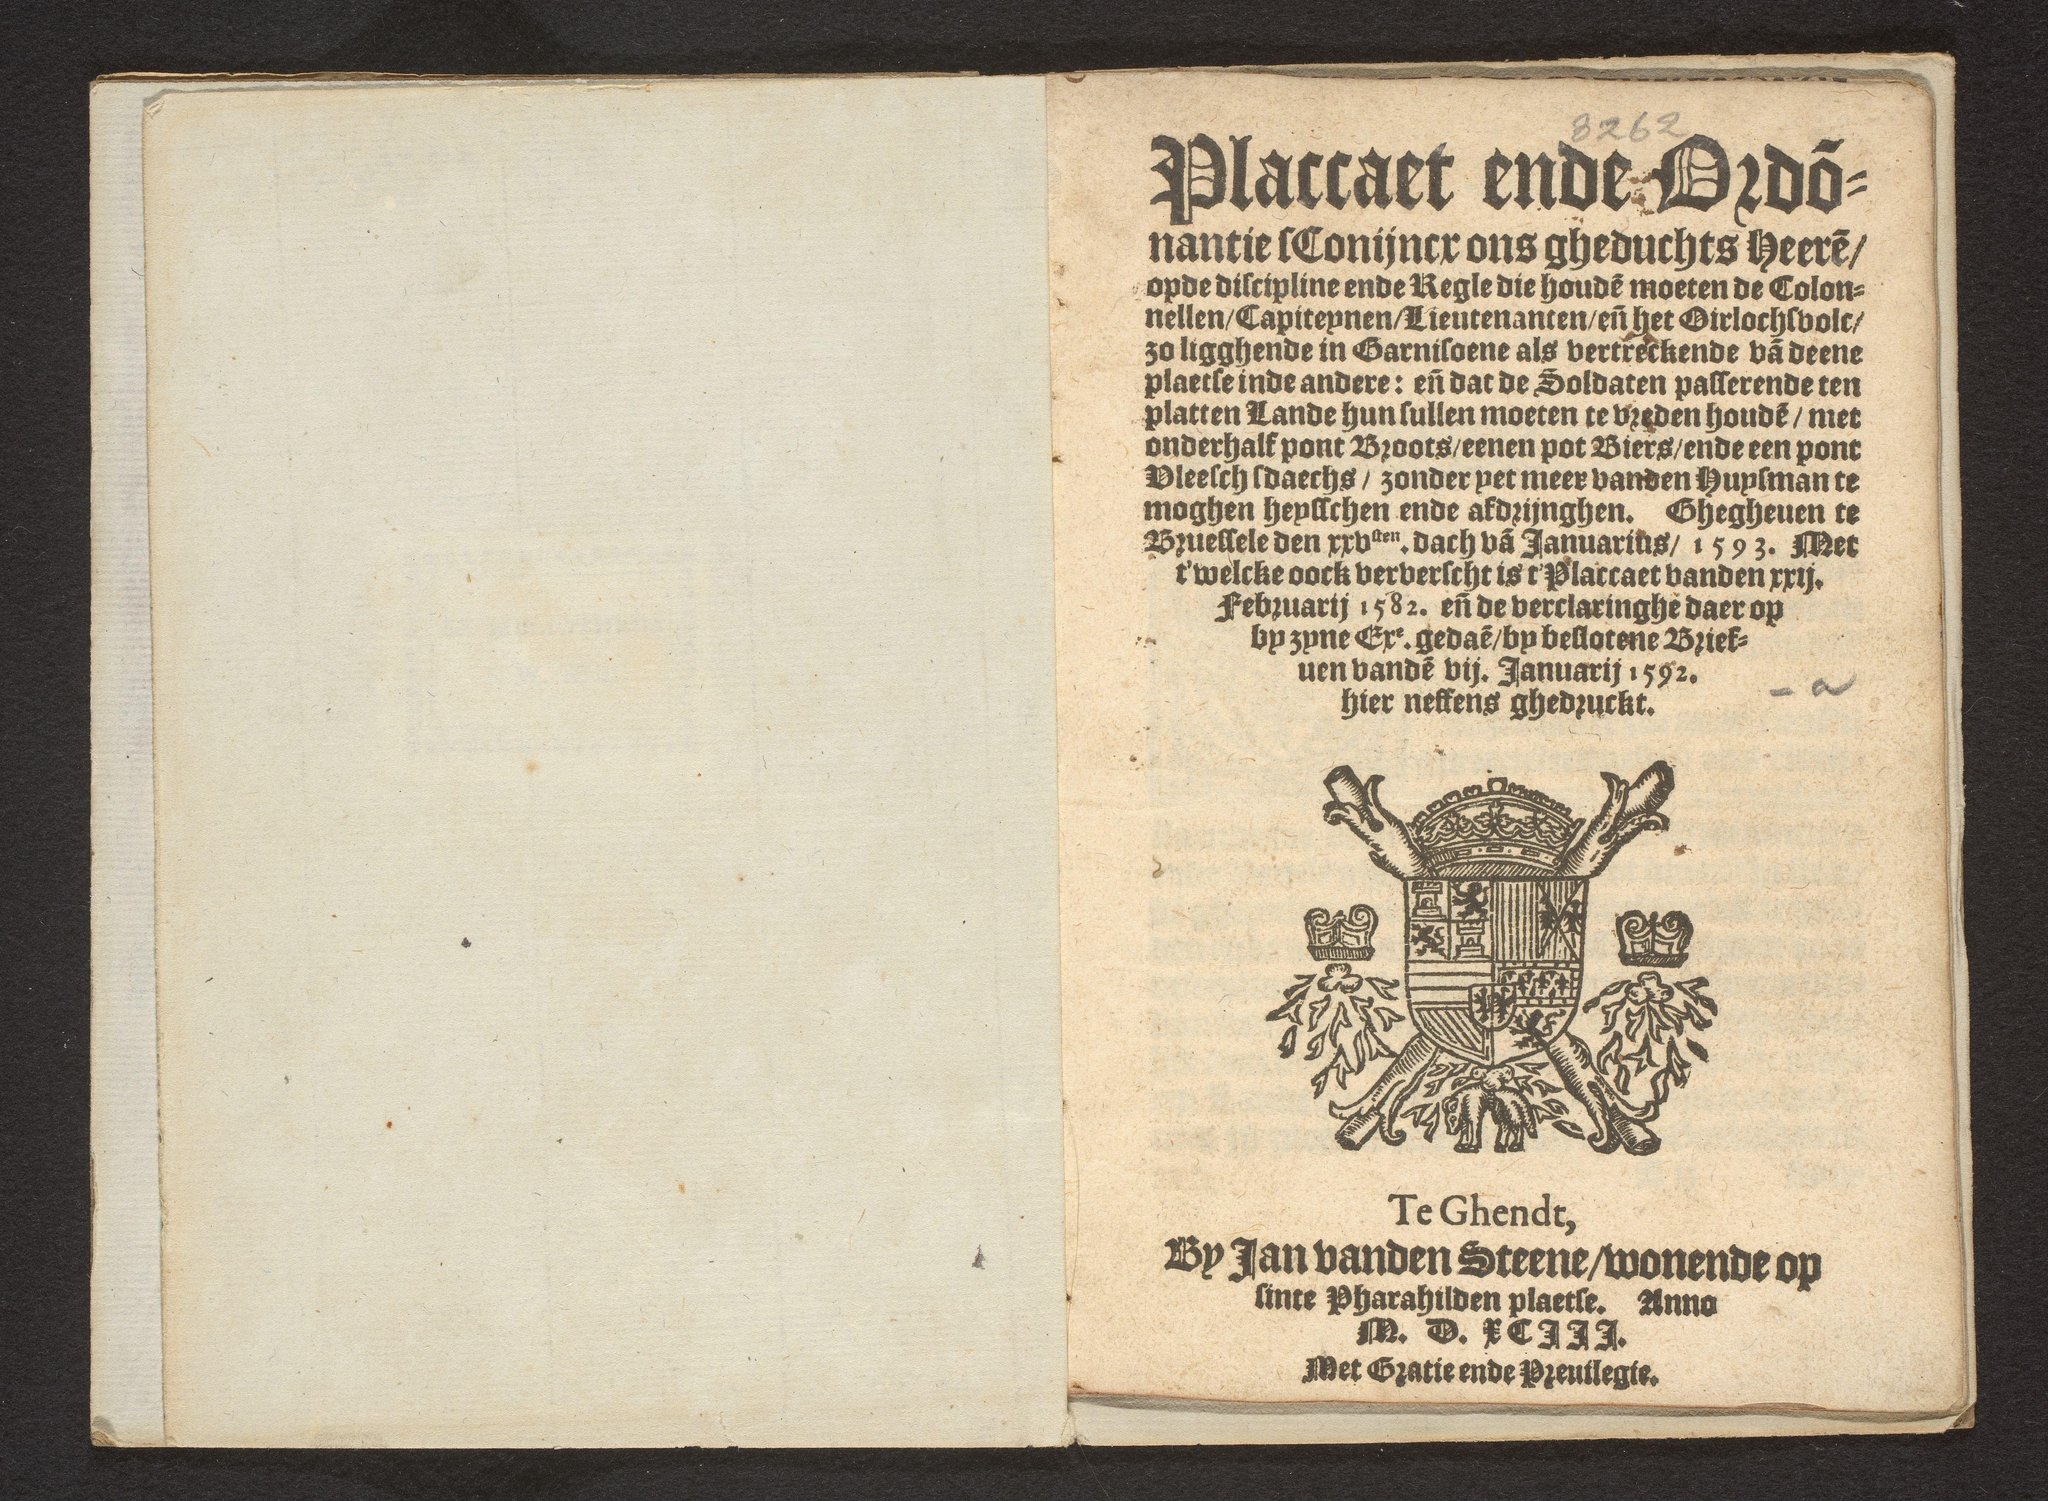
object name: book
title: Placcaet ende Ordonnantie sConyncx ons Gheduchts Heere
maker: jan van den steene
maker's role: publisher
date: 1593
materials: cardboard, paper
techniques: bookbinding, printing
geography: ghent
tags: tachtigjarige oorlog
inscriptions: date